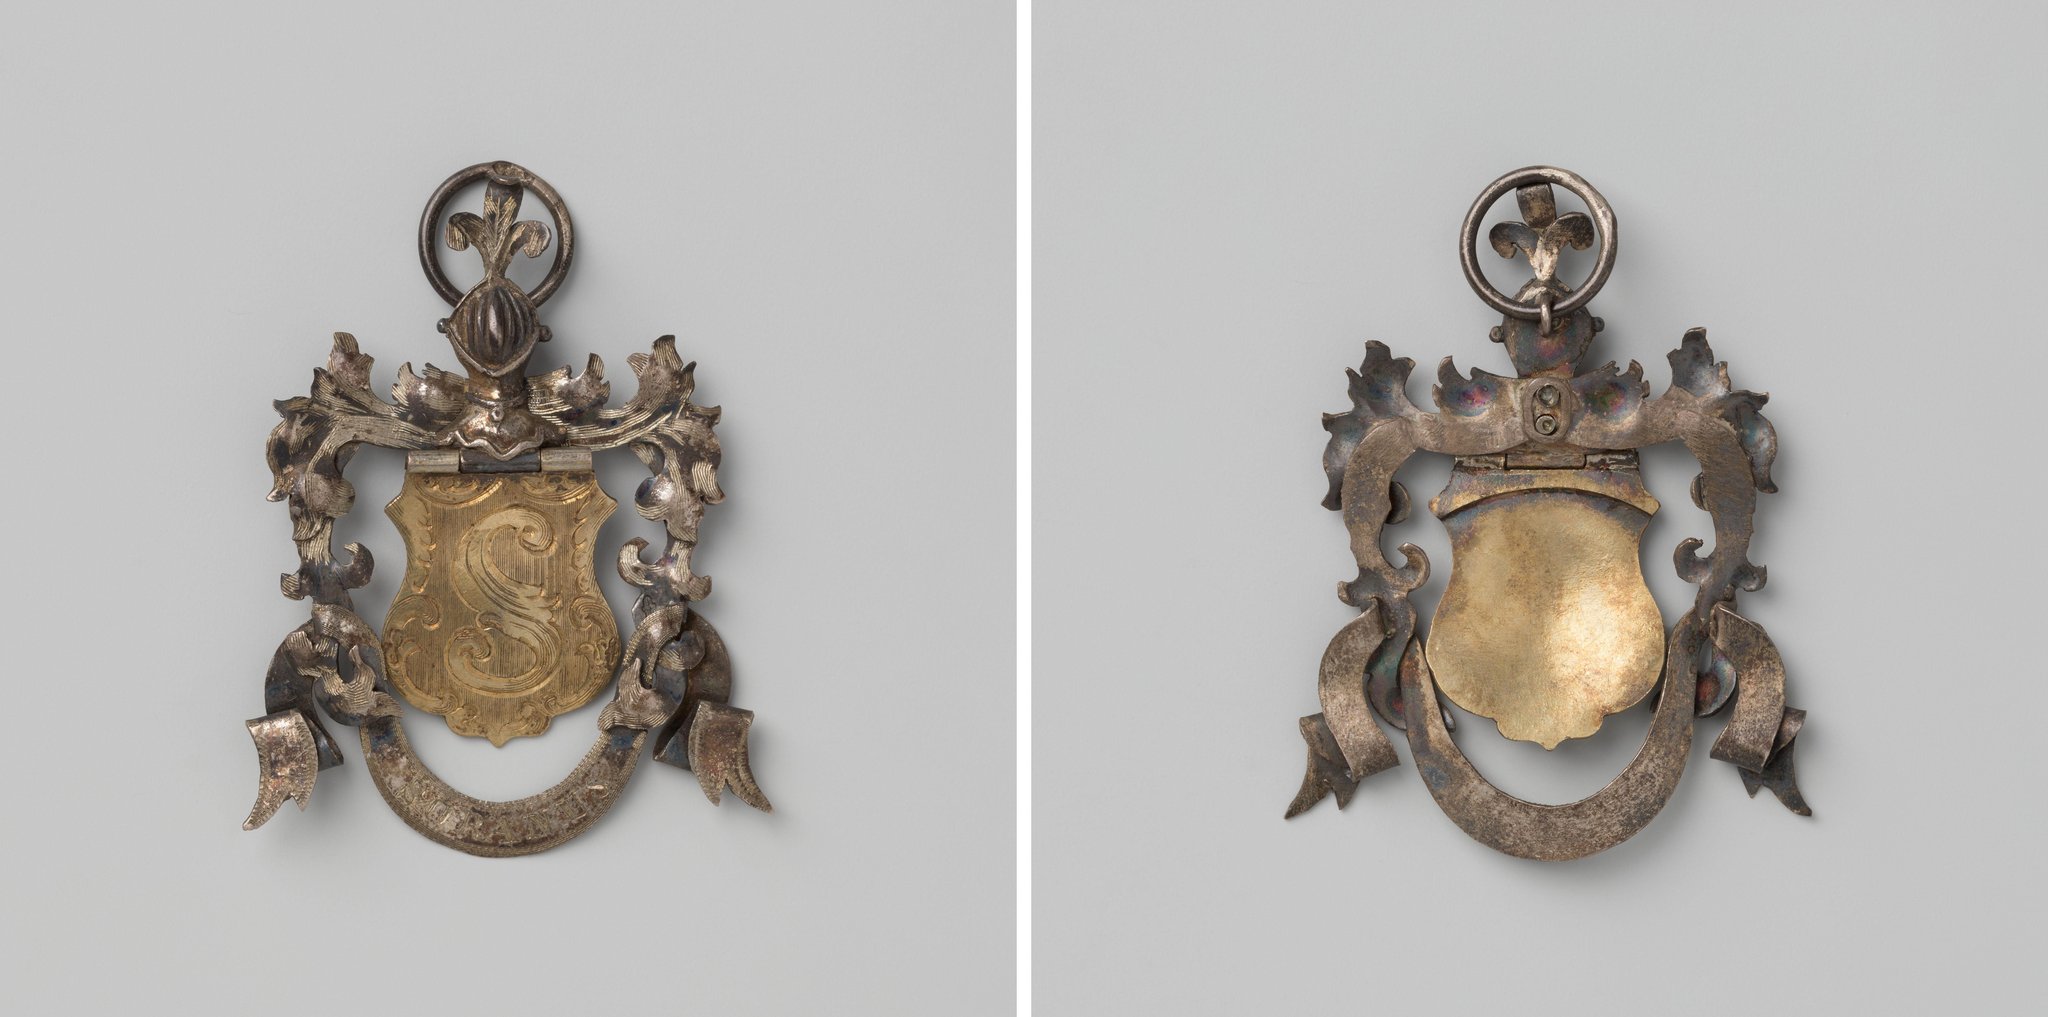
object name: insignia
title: Schuttersvereniging 'Soranus'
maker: Anonymous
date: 1825-1875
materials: silver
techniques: engraving, gilding, striking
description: Eenzijdig, opengewerkt zilveren insigne aan draagring, opgebouwd uit verguld wapenschild met versierde letter S, omgeven door ornament; met scharnier is schild bevestigd aan helm, bekroond met drie veren en omgeven door pluimen, waaraan lint met opschrift "SORANUS" hangt.